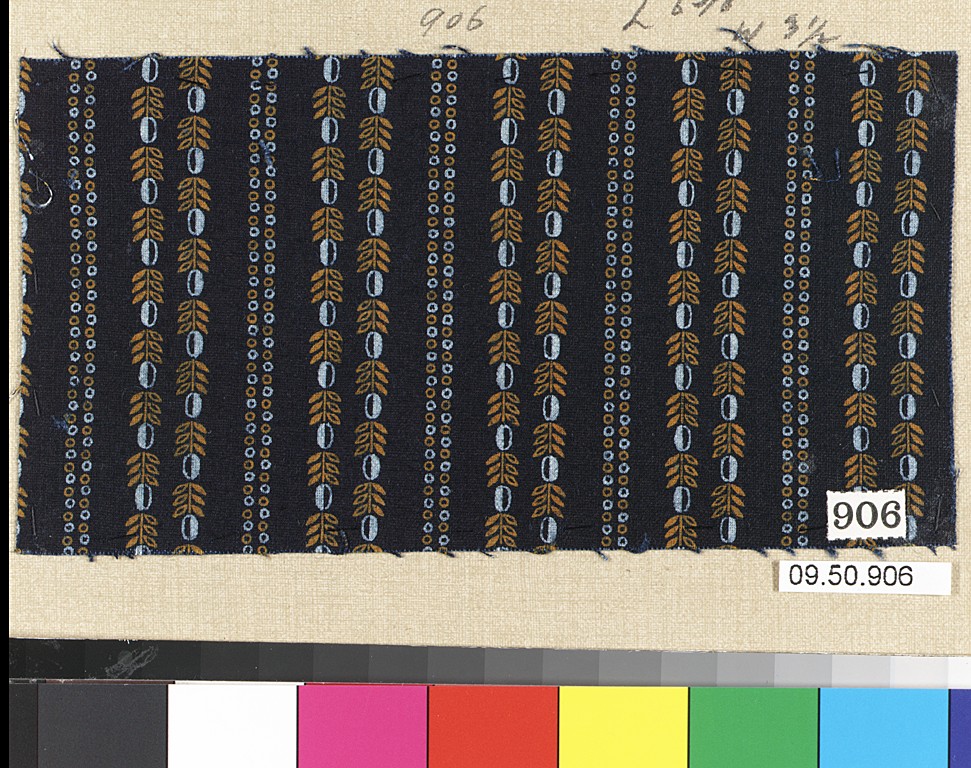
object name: piece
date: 1801-1900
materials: cotton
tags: leaves